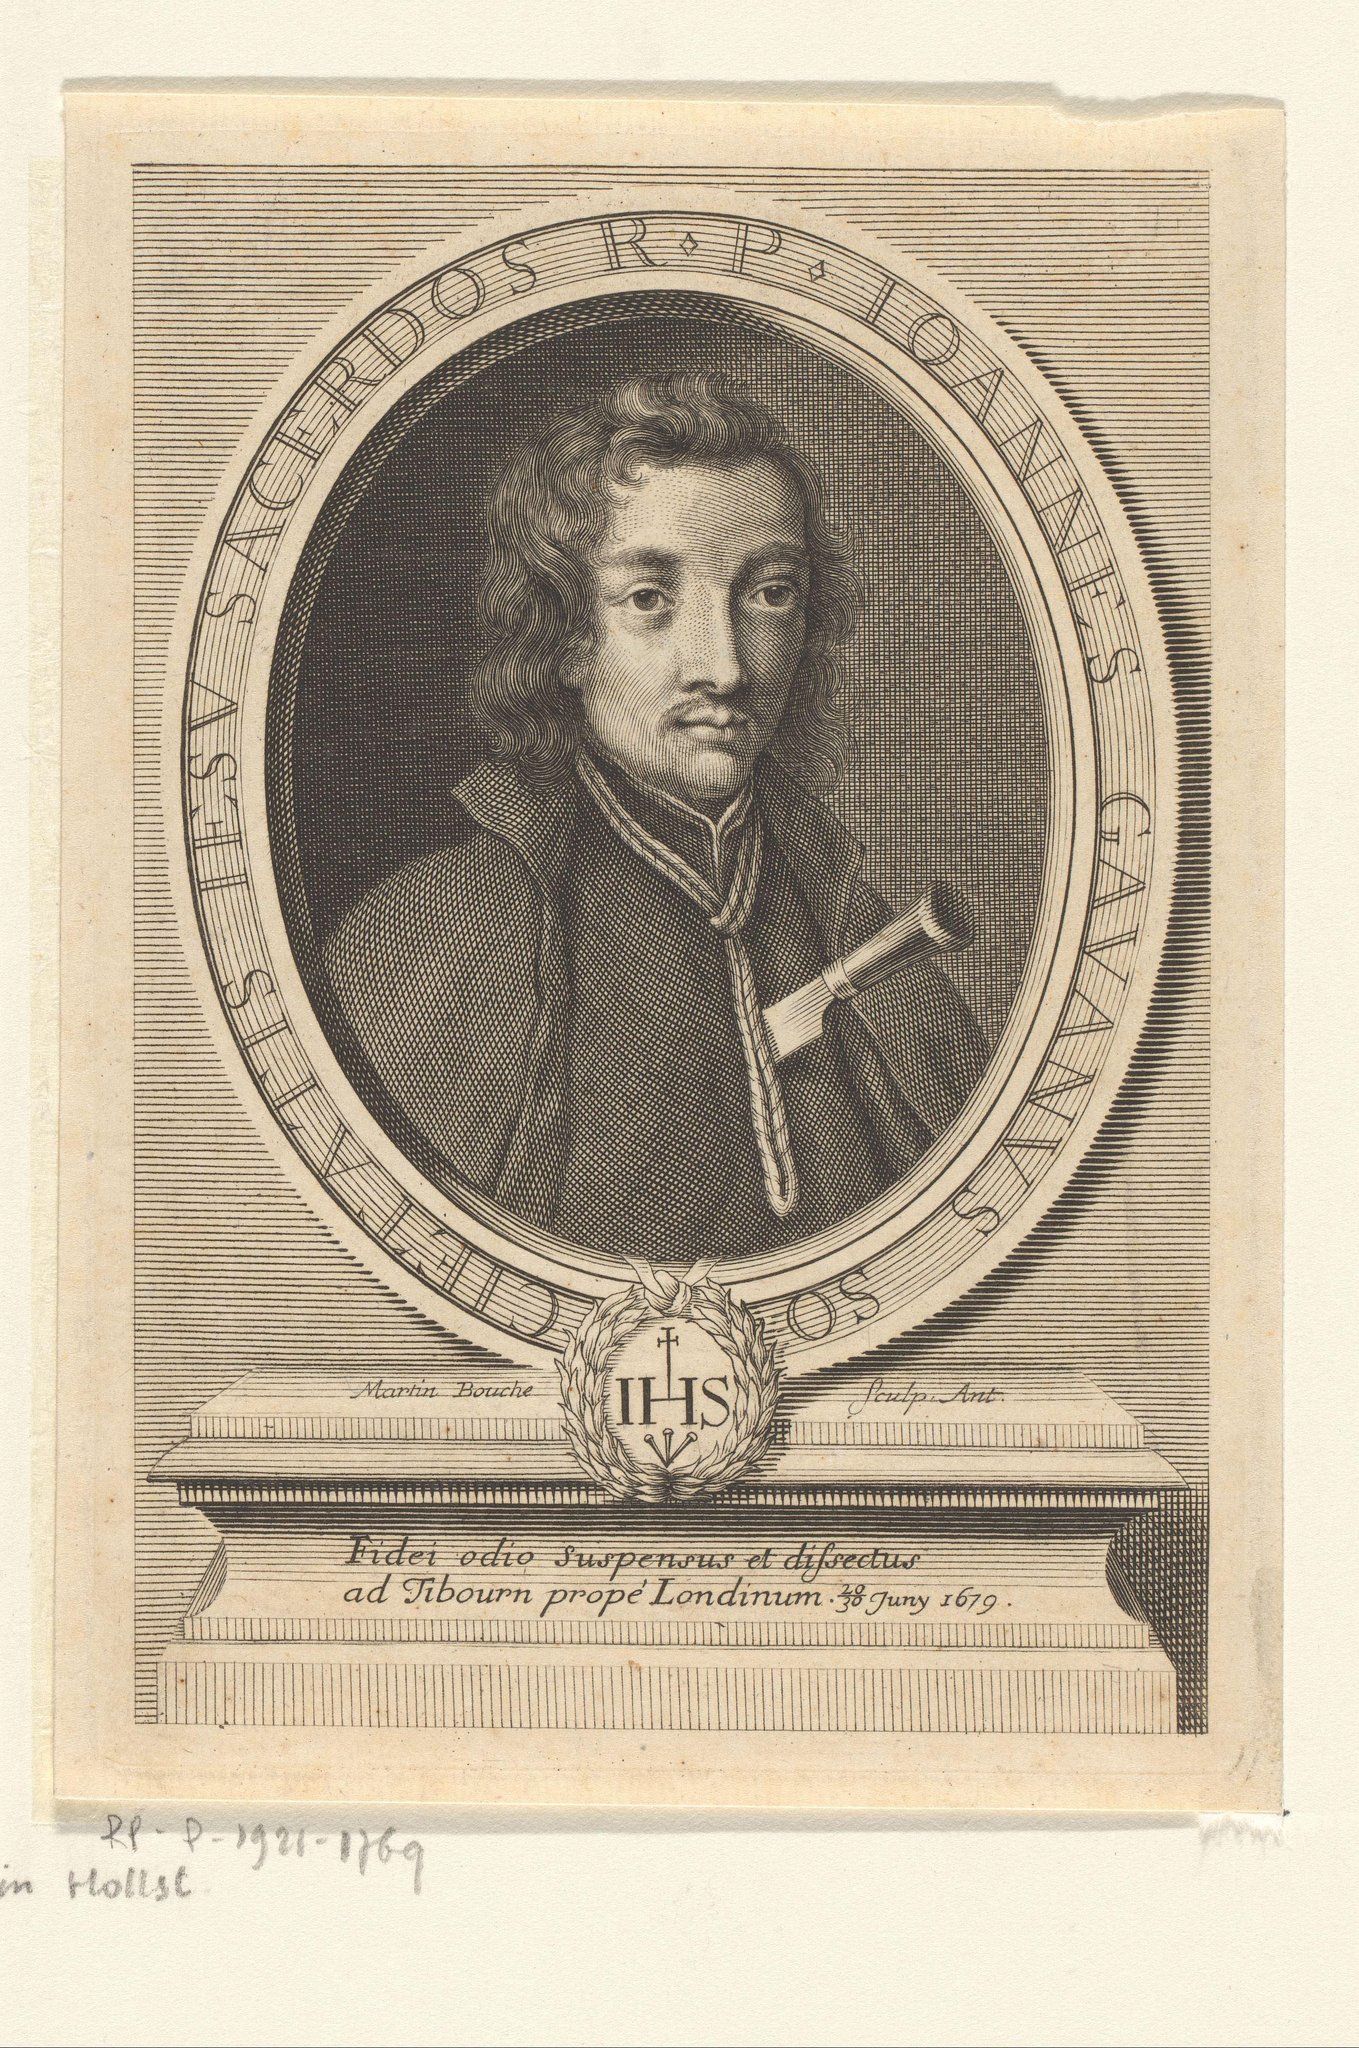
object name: print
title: Joh. Gavanus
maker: martin bouche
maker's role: print maker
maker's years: 1640-1693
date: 1650-1693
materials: paper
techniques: engraving